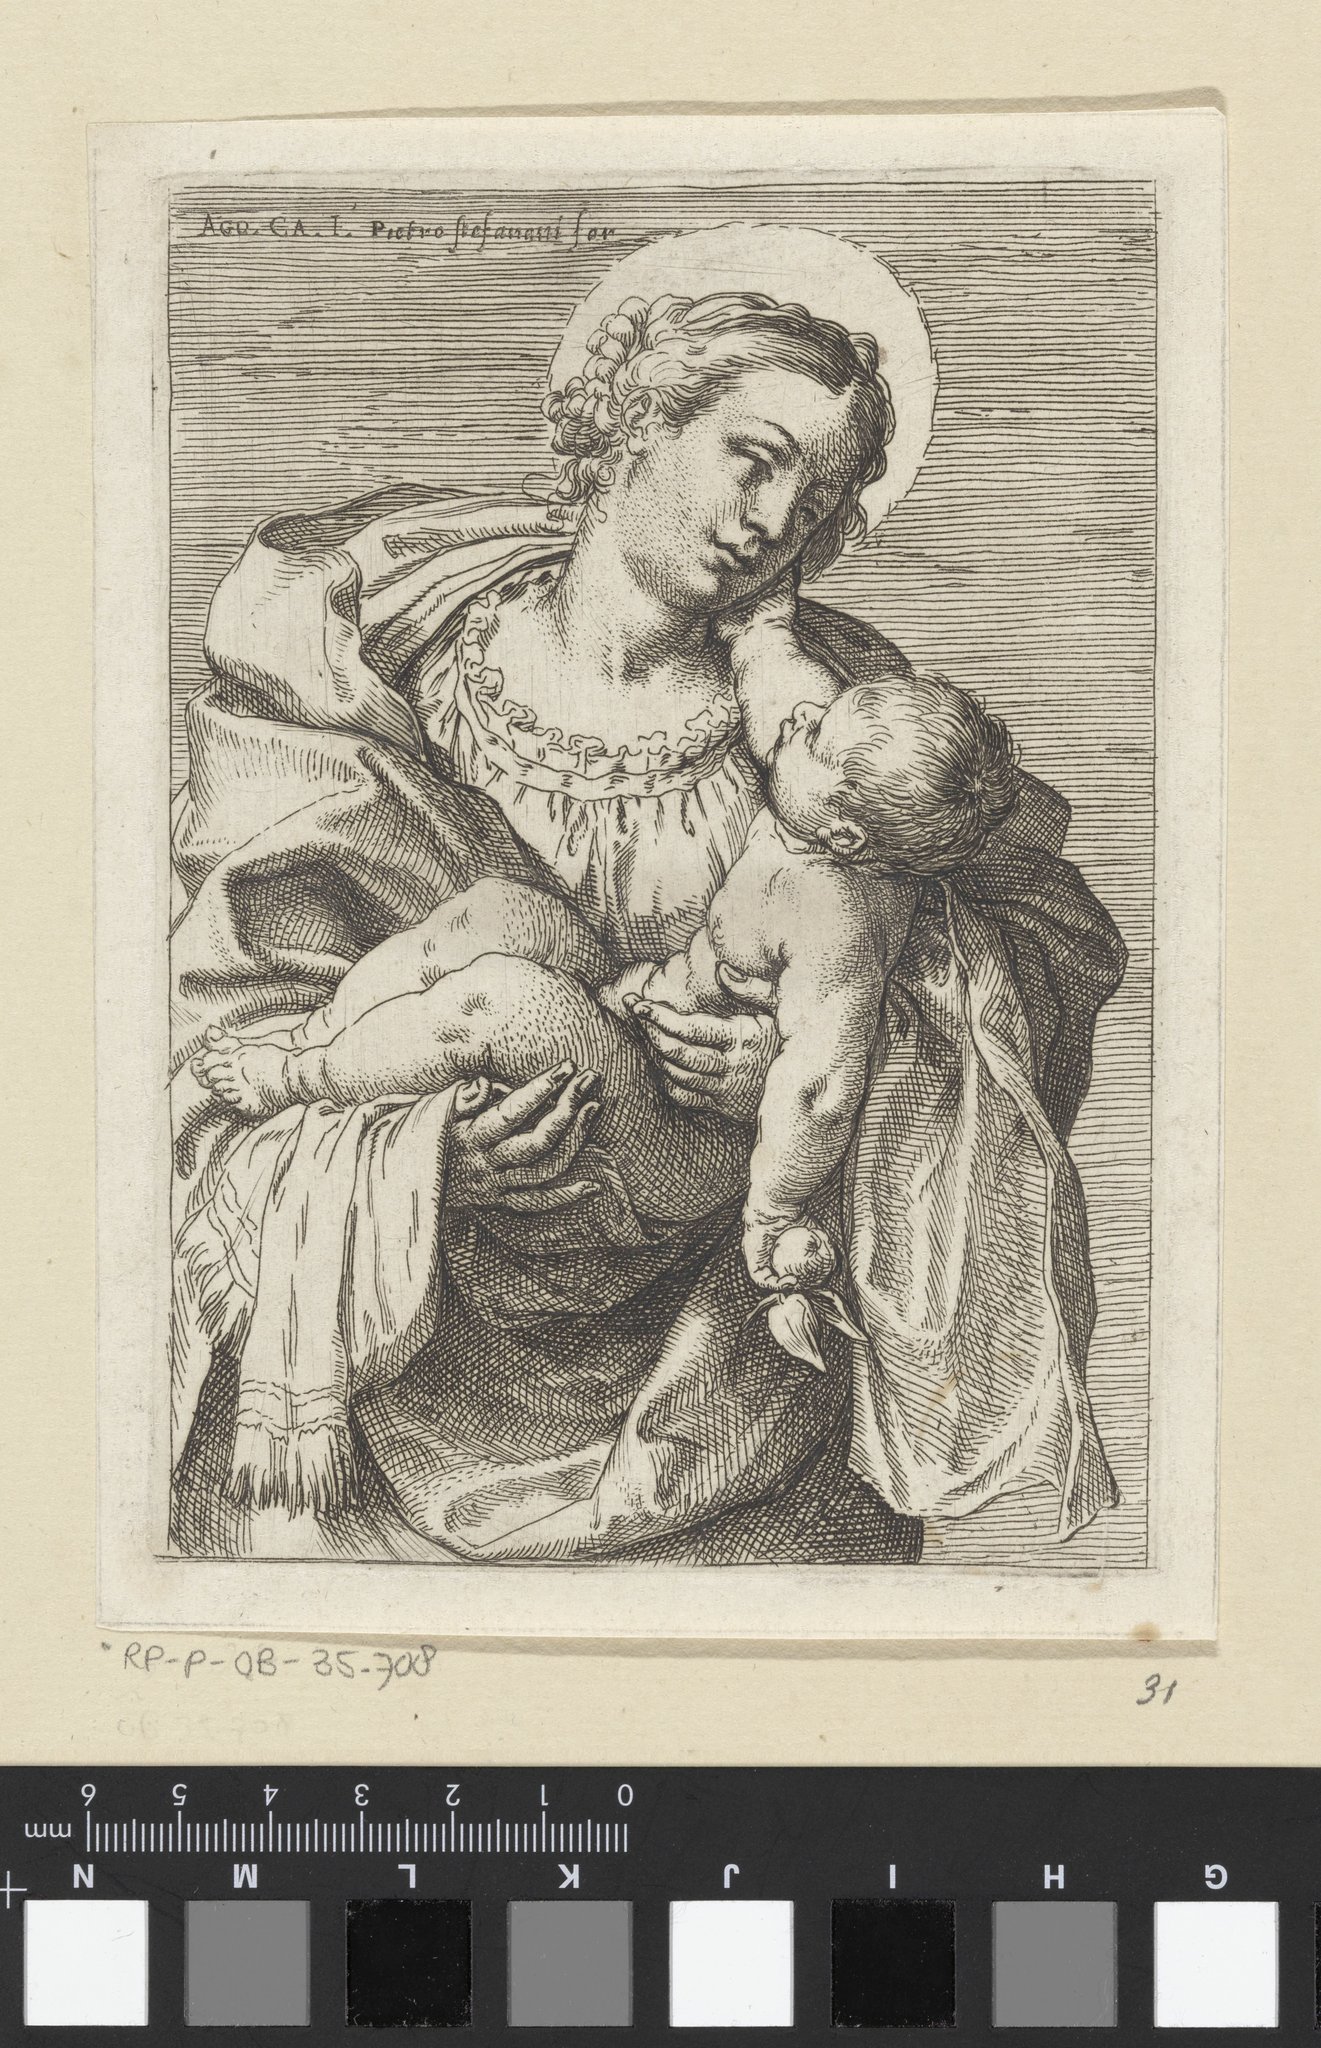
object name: print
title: Maria met Kind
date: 1570-1609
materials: paper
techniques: etching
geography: italy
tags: madonna: i.e. mary with the christ-child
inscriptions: inscription: Lugt 240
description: Maria staat met het Christuskind in haar armen.